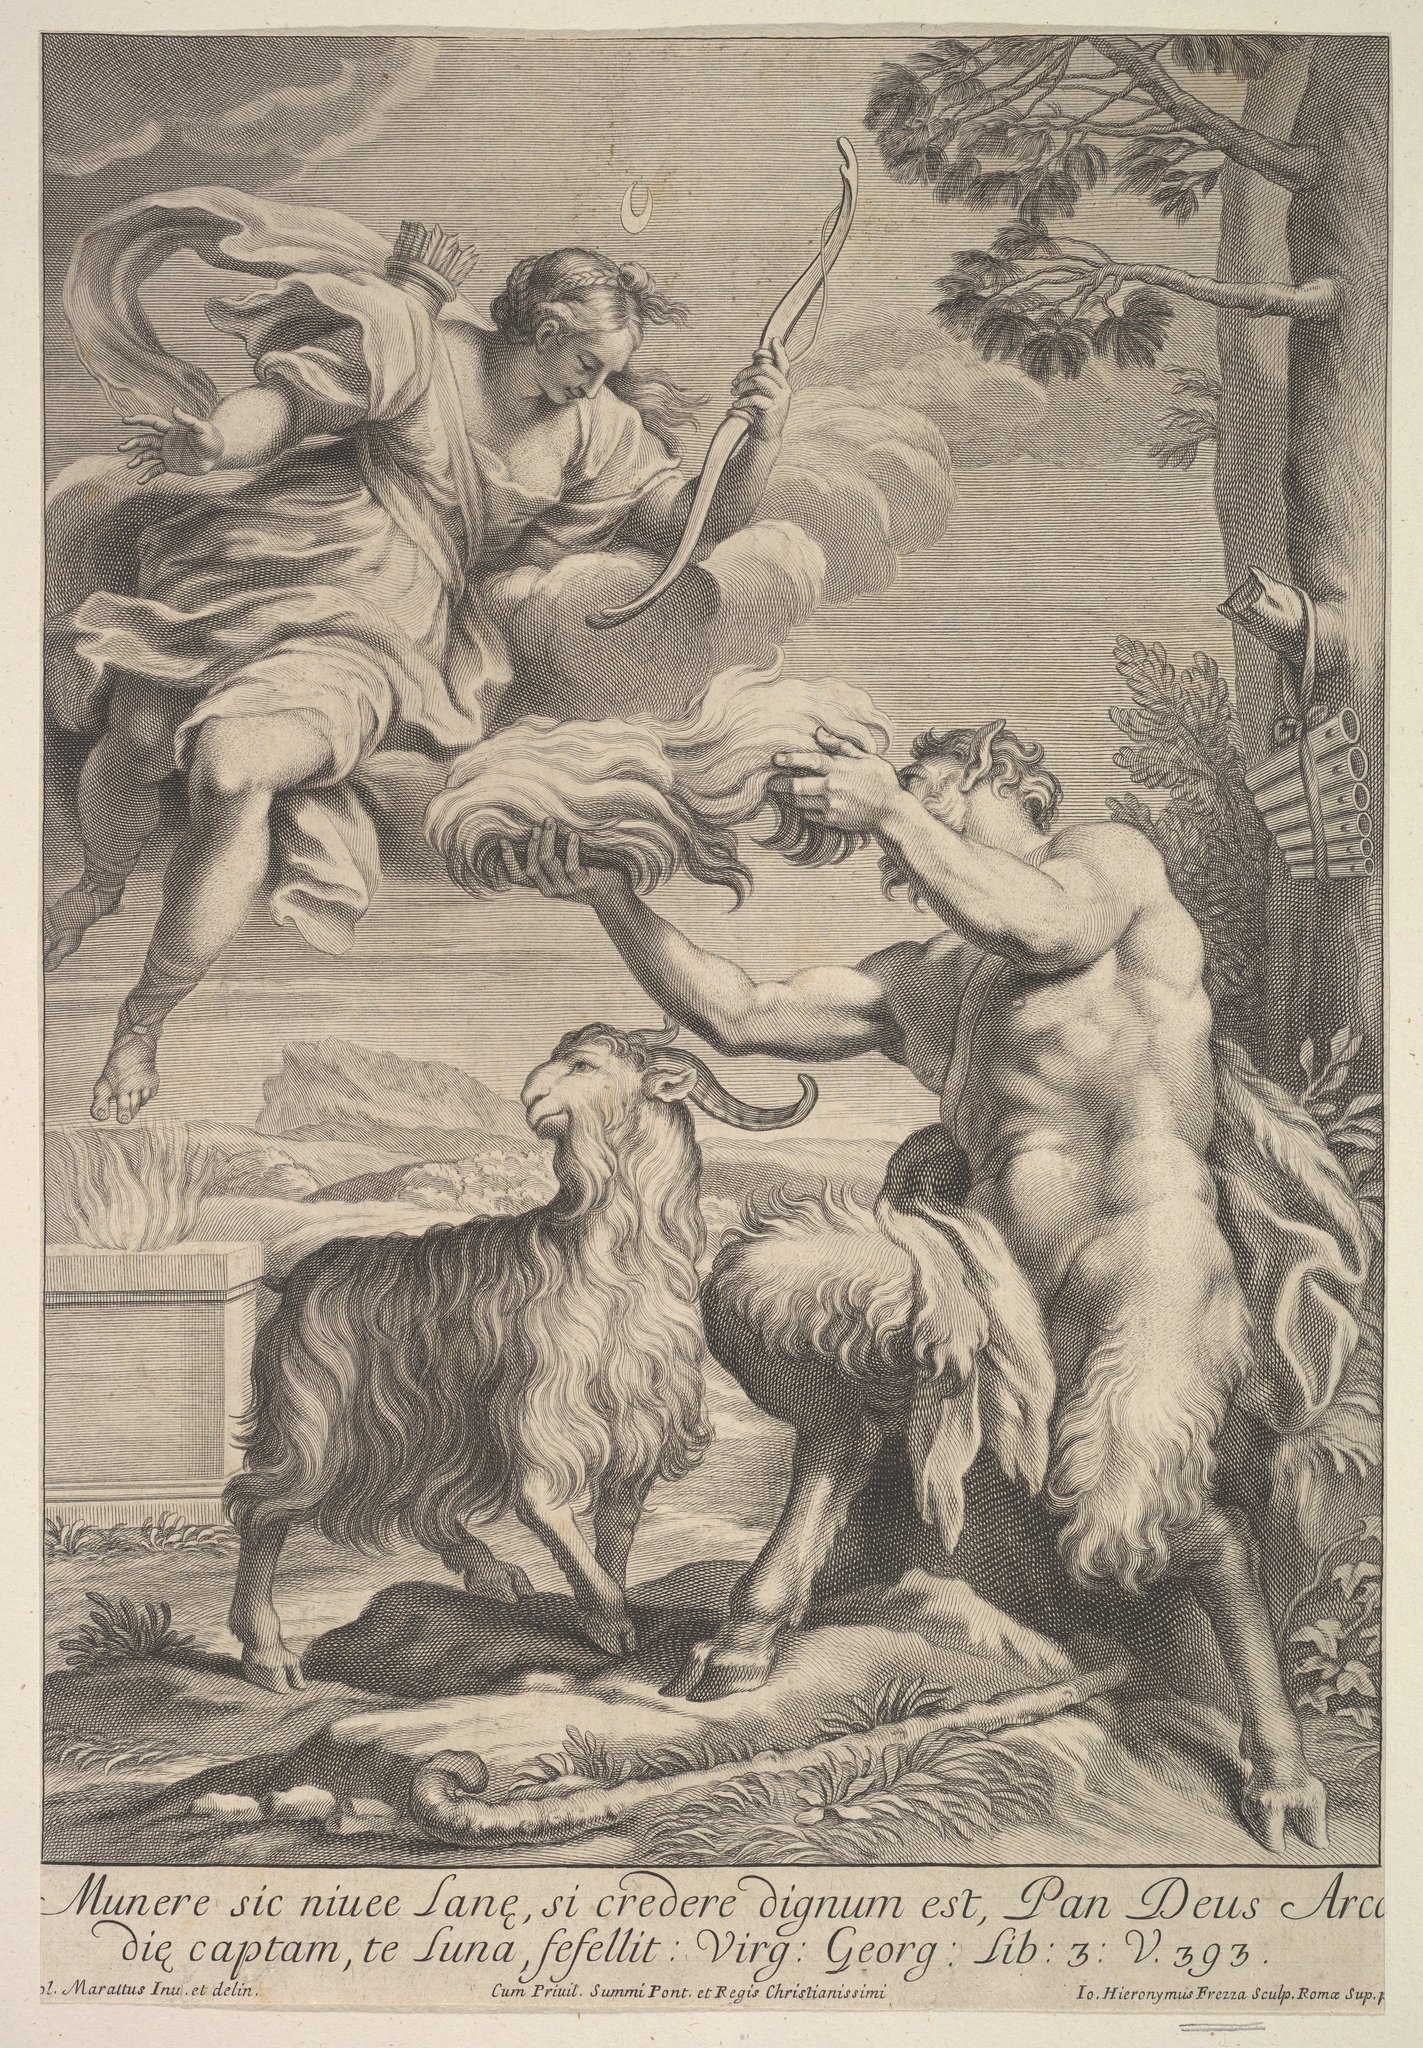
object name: print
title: Pan foiled by Diana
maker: giovanni girolamo frezza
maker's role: artist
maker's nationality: italian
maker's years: 1671-1753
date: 1675-1741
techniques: engraving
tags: diana,satyrs,goats